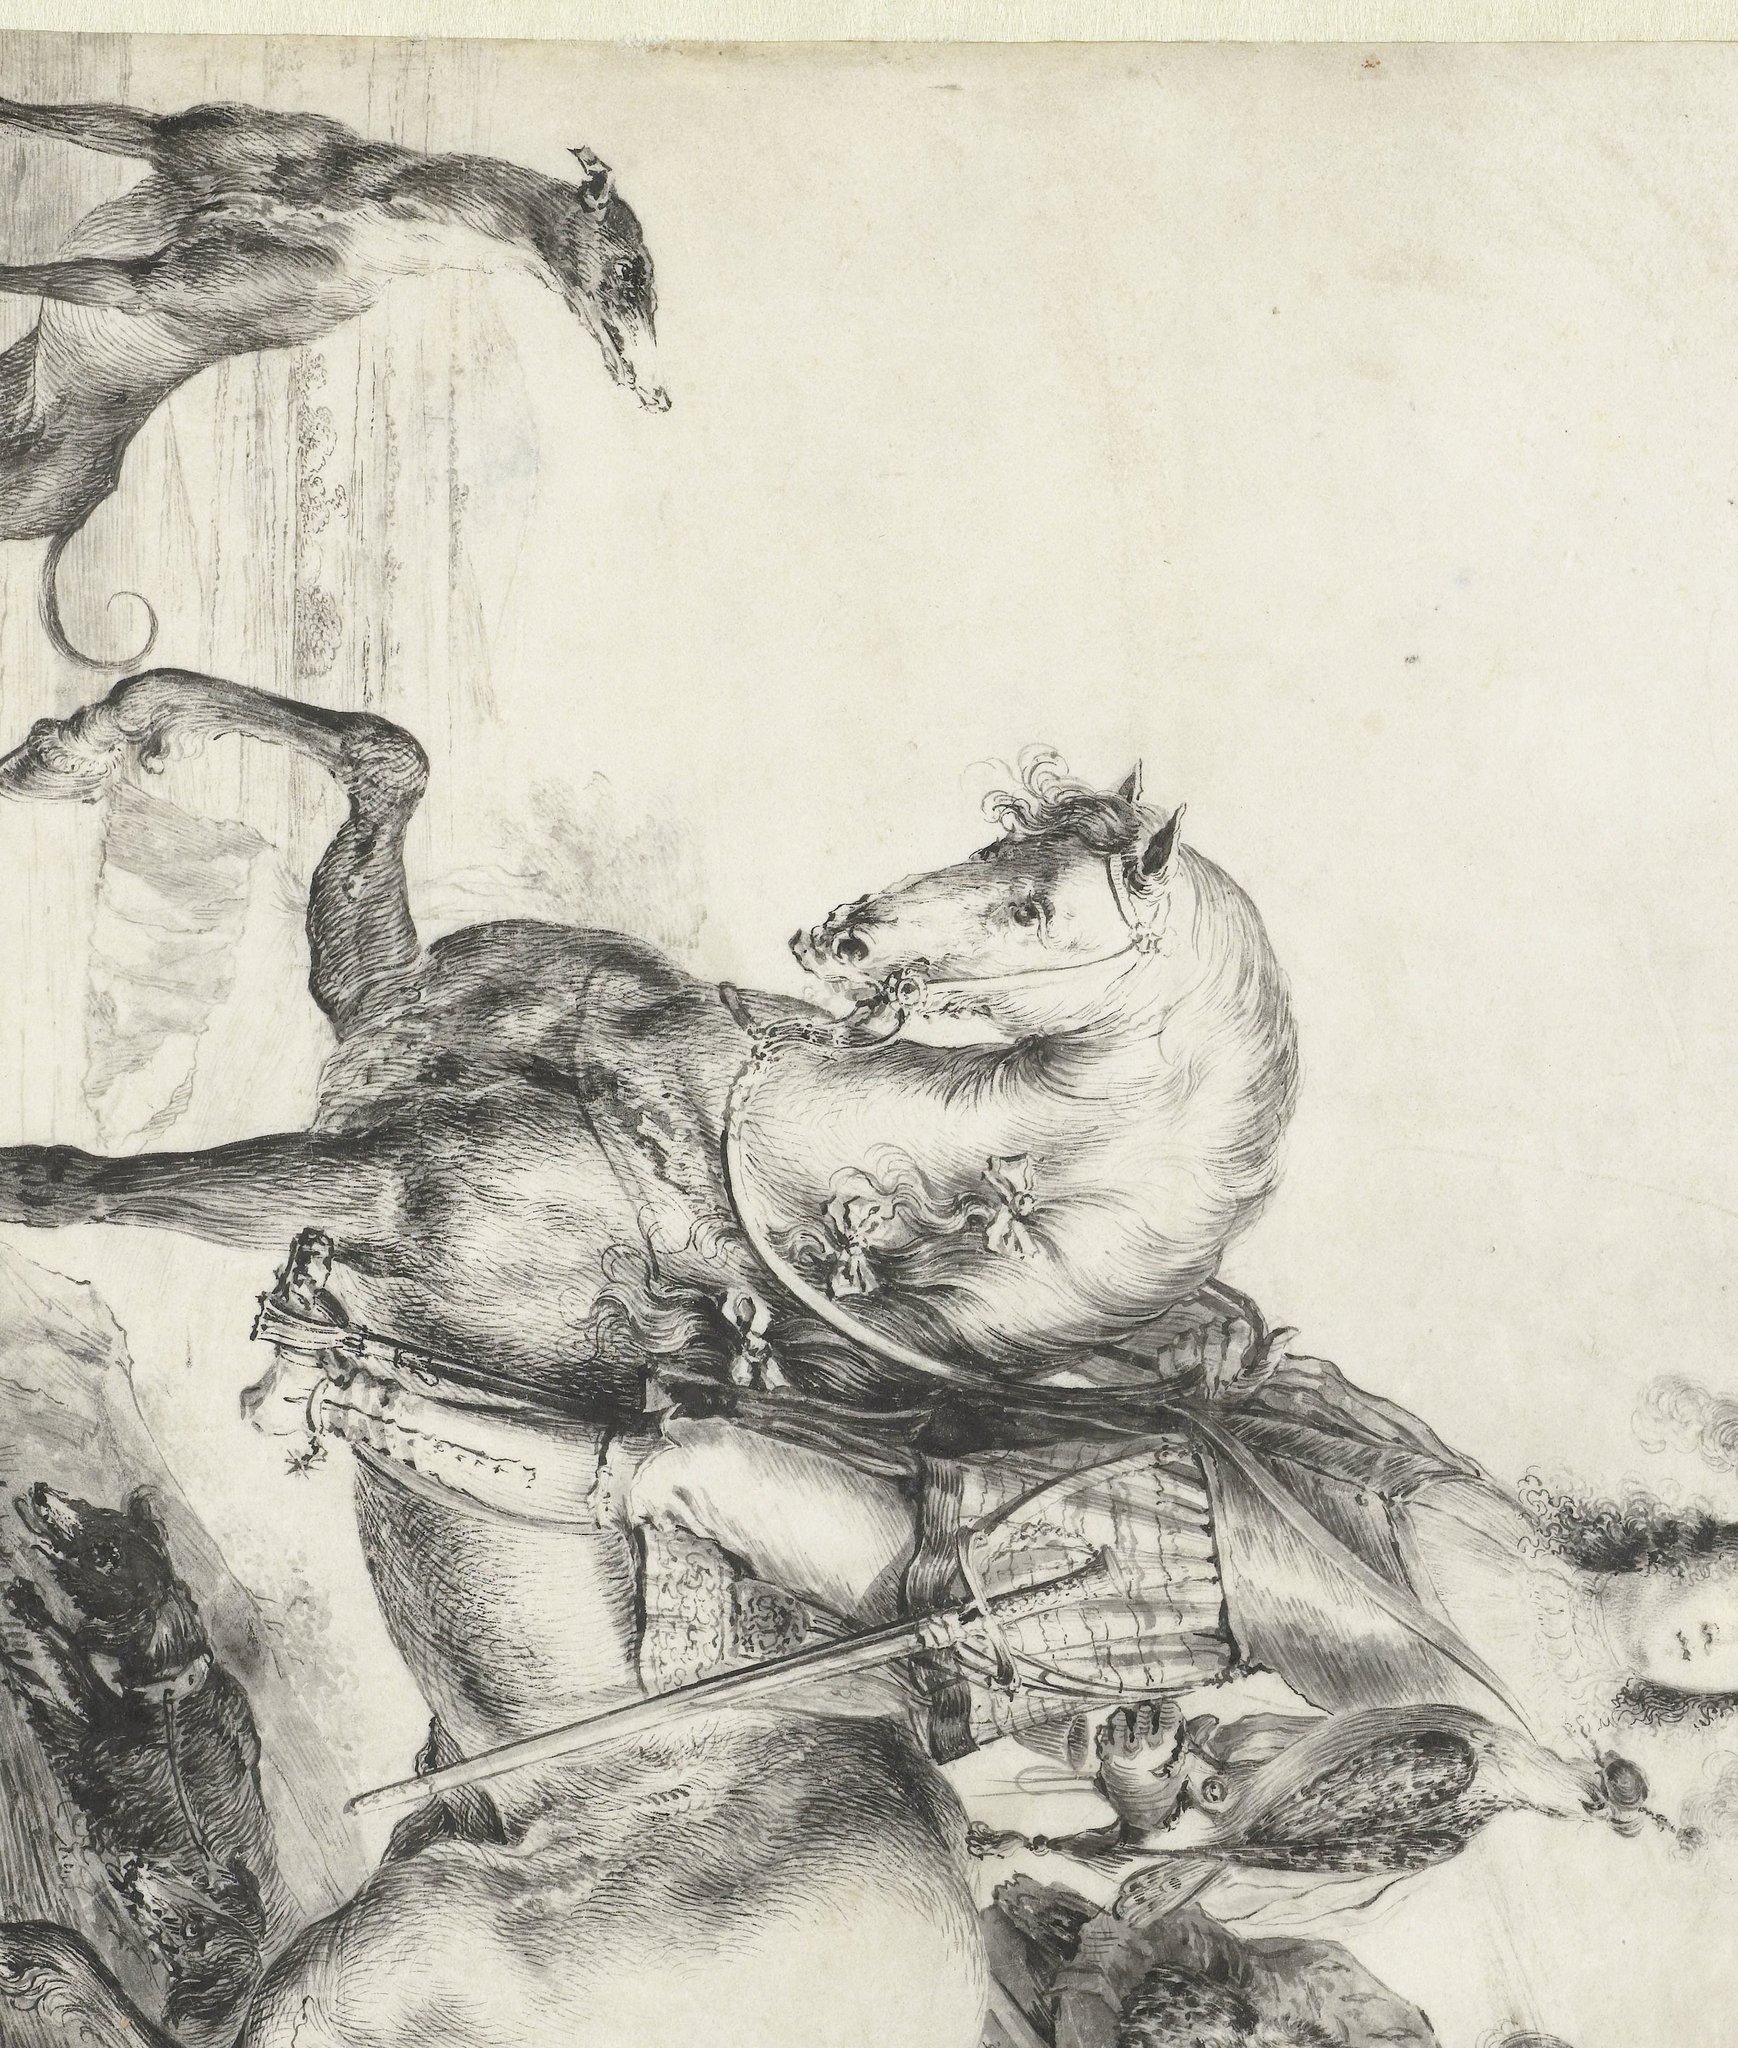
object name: drawing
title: Heer te paard op valkenjacht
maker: pieter rottermondt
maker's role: draughtsman, print maker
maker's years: -1706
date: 1632-1710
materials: ink, parchment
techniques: brush, pen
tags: hunting dogs, hunter, bird hunting, owls, bird hunting (+ hunting with falcon, hawk; falconry)